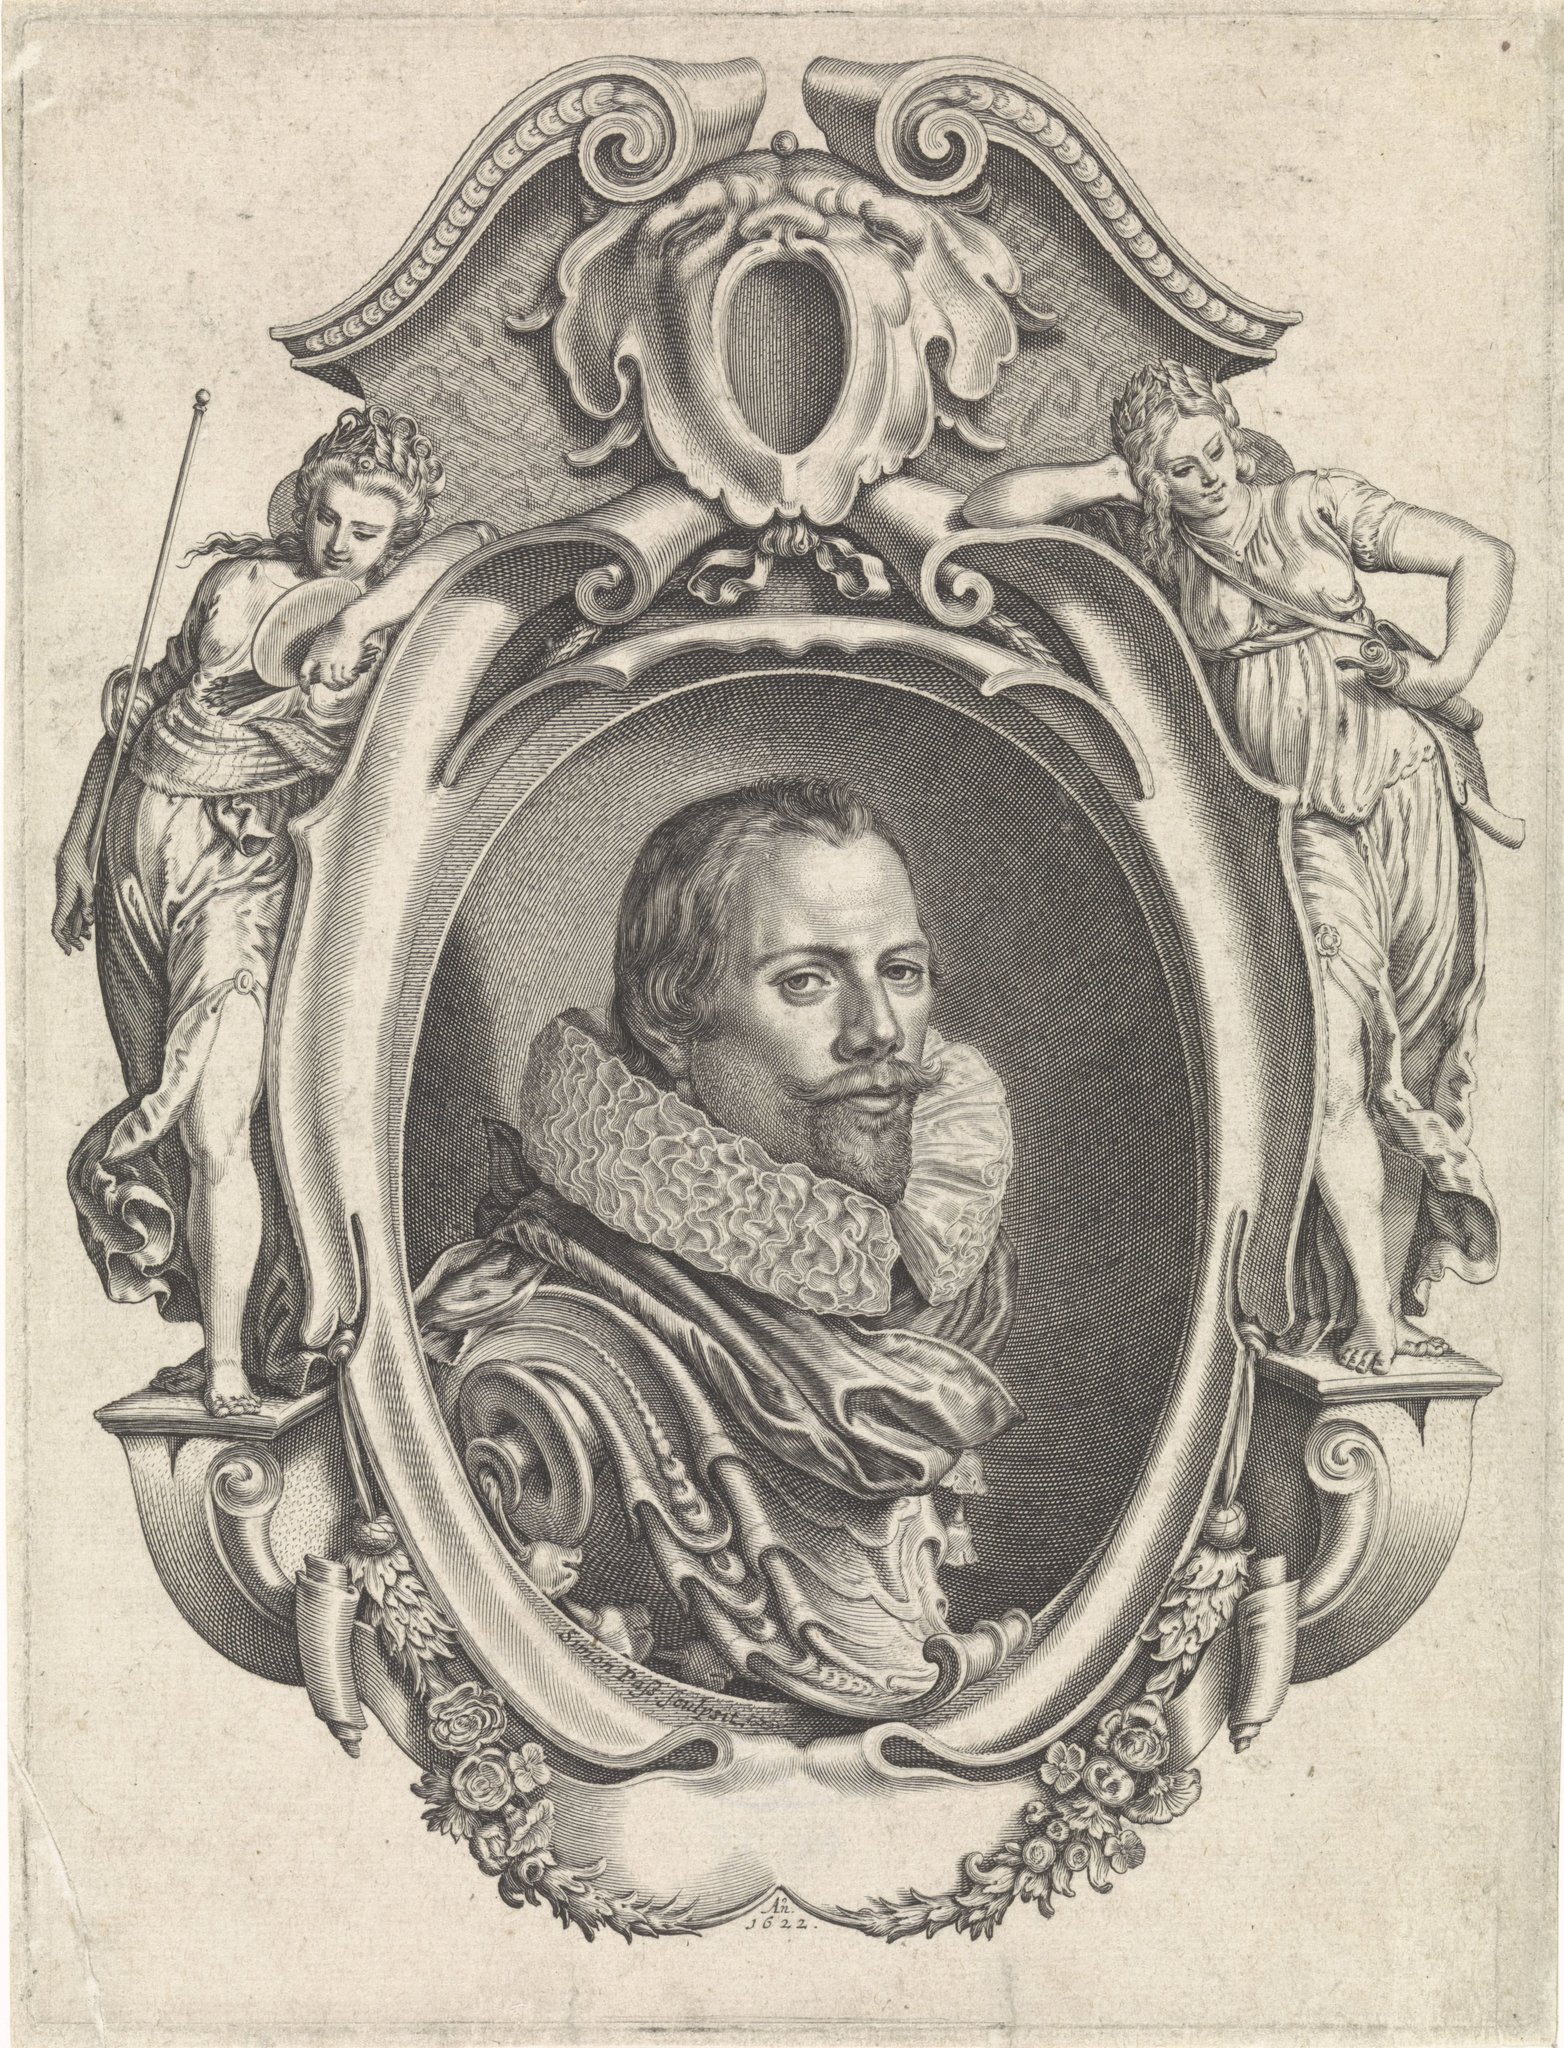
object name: print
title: Portret van Hendrik Arentsen Vapoer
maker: simon van de passe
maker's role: print maker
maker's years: 1595-1647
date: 1622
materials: paper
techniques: engraving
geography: london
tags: painter, 'pictura', symbolic representations, allegories and emblems ~ painting; 'pittura' (ripa), symbolic representations, allegories and emblems ~ poetry; 'poesia' (ripa)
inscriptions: collector's mark: Lugt 2228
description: Portret van de schilder Hendrik Arentsen Vapoer. Het portret is gevat in een ornamentele omlijsting en wordt geflankeerd door de personificaties van Schilderkunst en Poëzie.